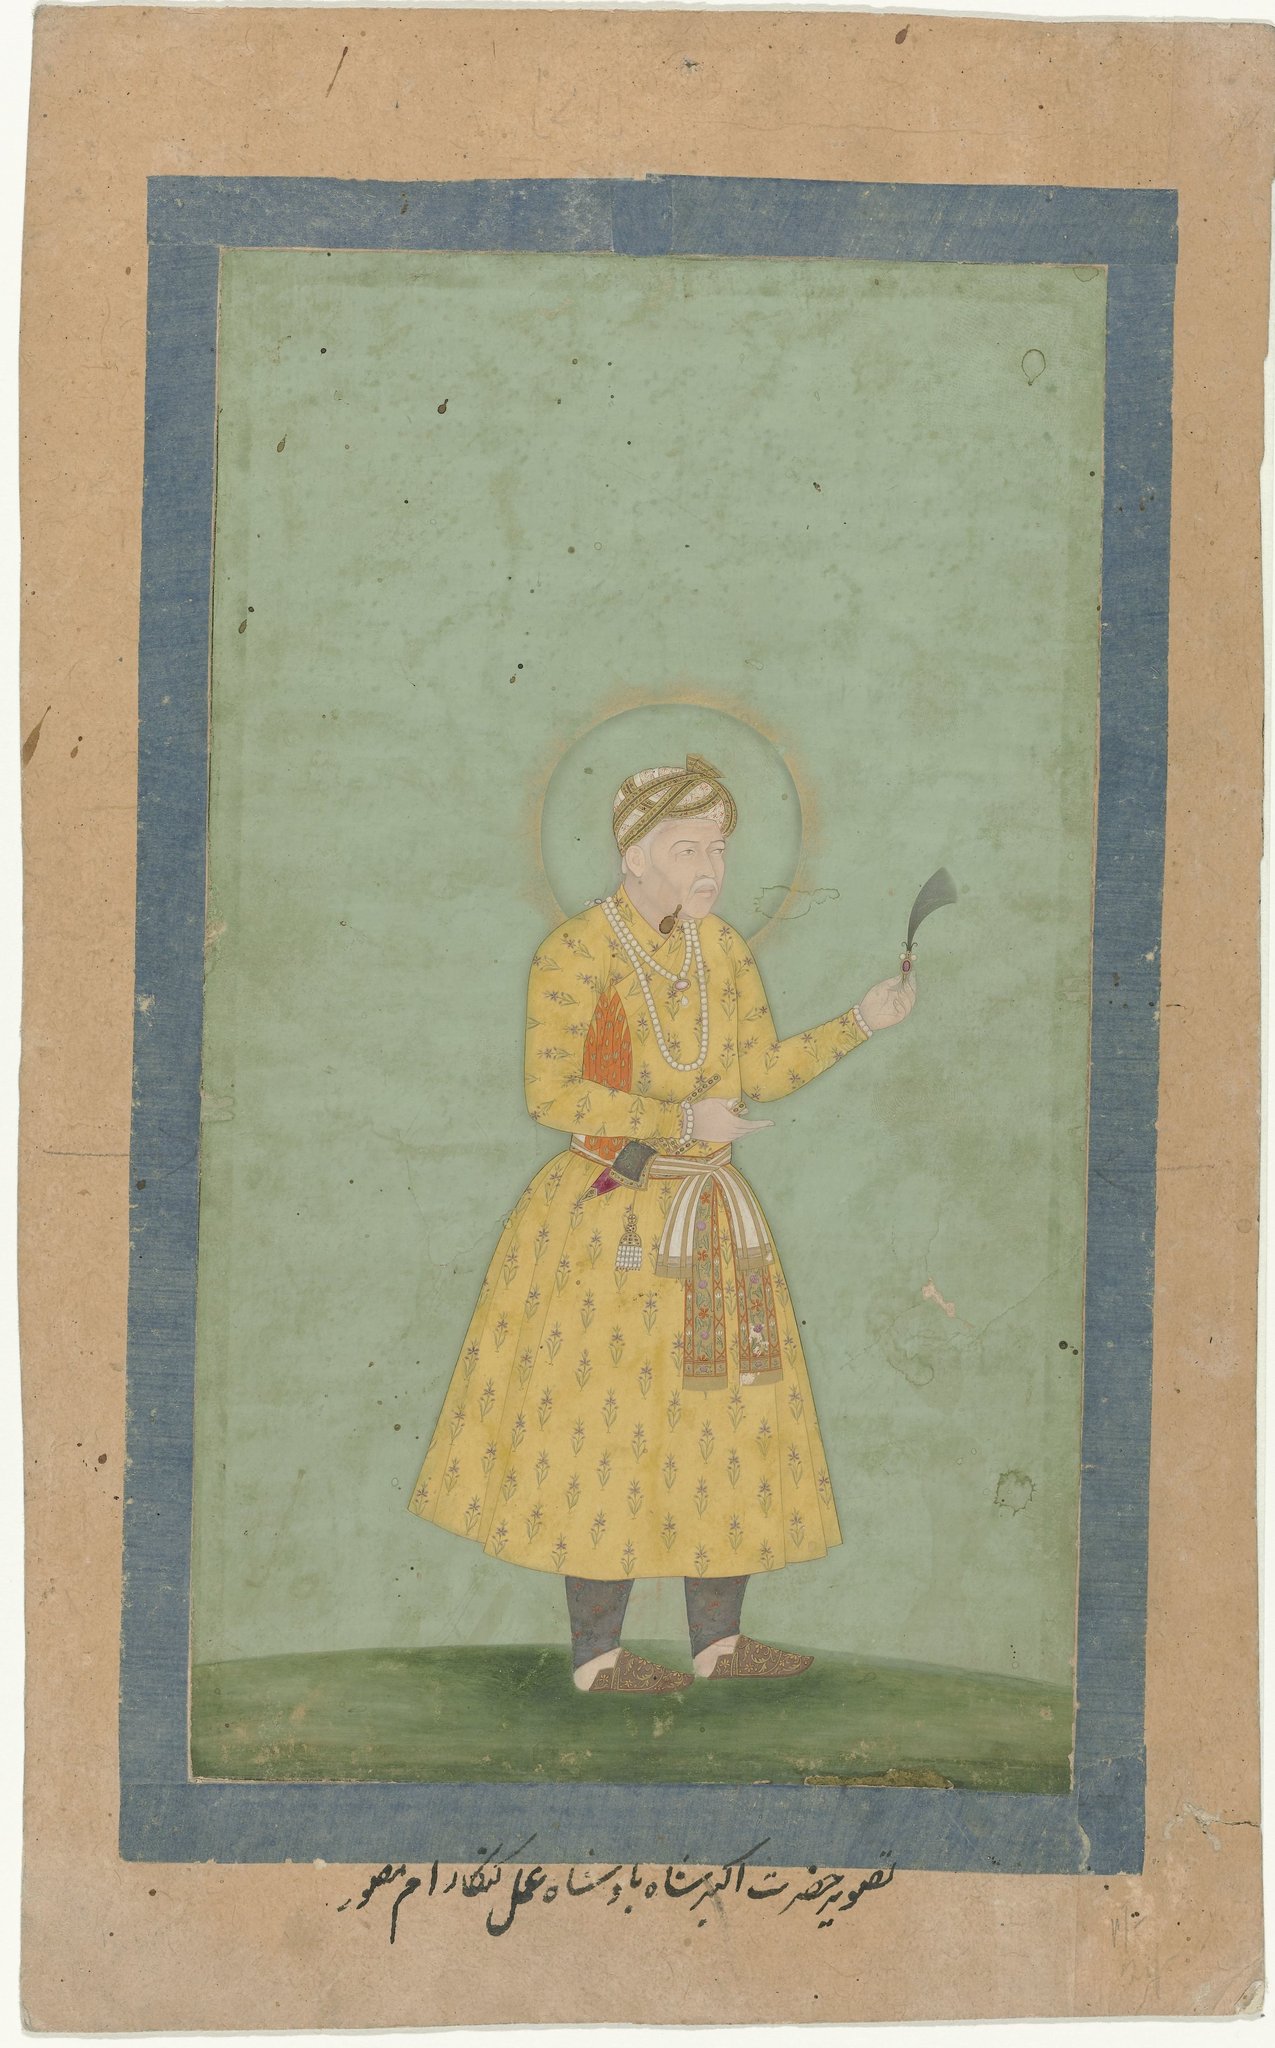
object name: drawing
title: Portret van Akbar, staand, met verenpluim in de hand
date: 1700-1710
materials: paper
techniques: brush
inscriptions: inscription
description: De Groot-Mogol Akbar is hier op oudere leeftijd voorgesteld. Hij staat met het gezicht in driekwart profiel naar rechts. Zijn gele jama is versierd met paarse bloemen en oranje linten voor de sluiting. In zijn linkerhand houdt hij een met edelstenen versierde verenpluim, die op de tulband gedragen wordt. Zijn tulband is op ouderwetse wijze opgebonden. Hij heeft, als alle vorsten en goden, een aureool. De achtergrond is effen groen. Rond de voorstelling een eenvoudige onversierde rand in blauw.